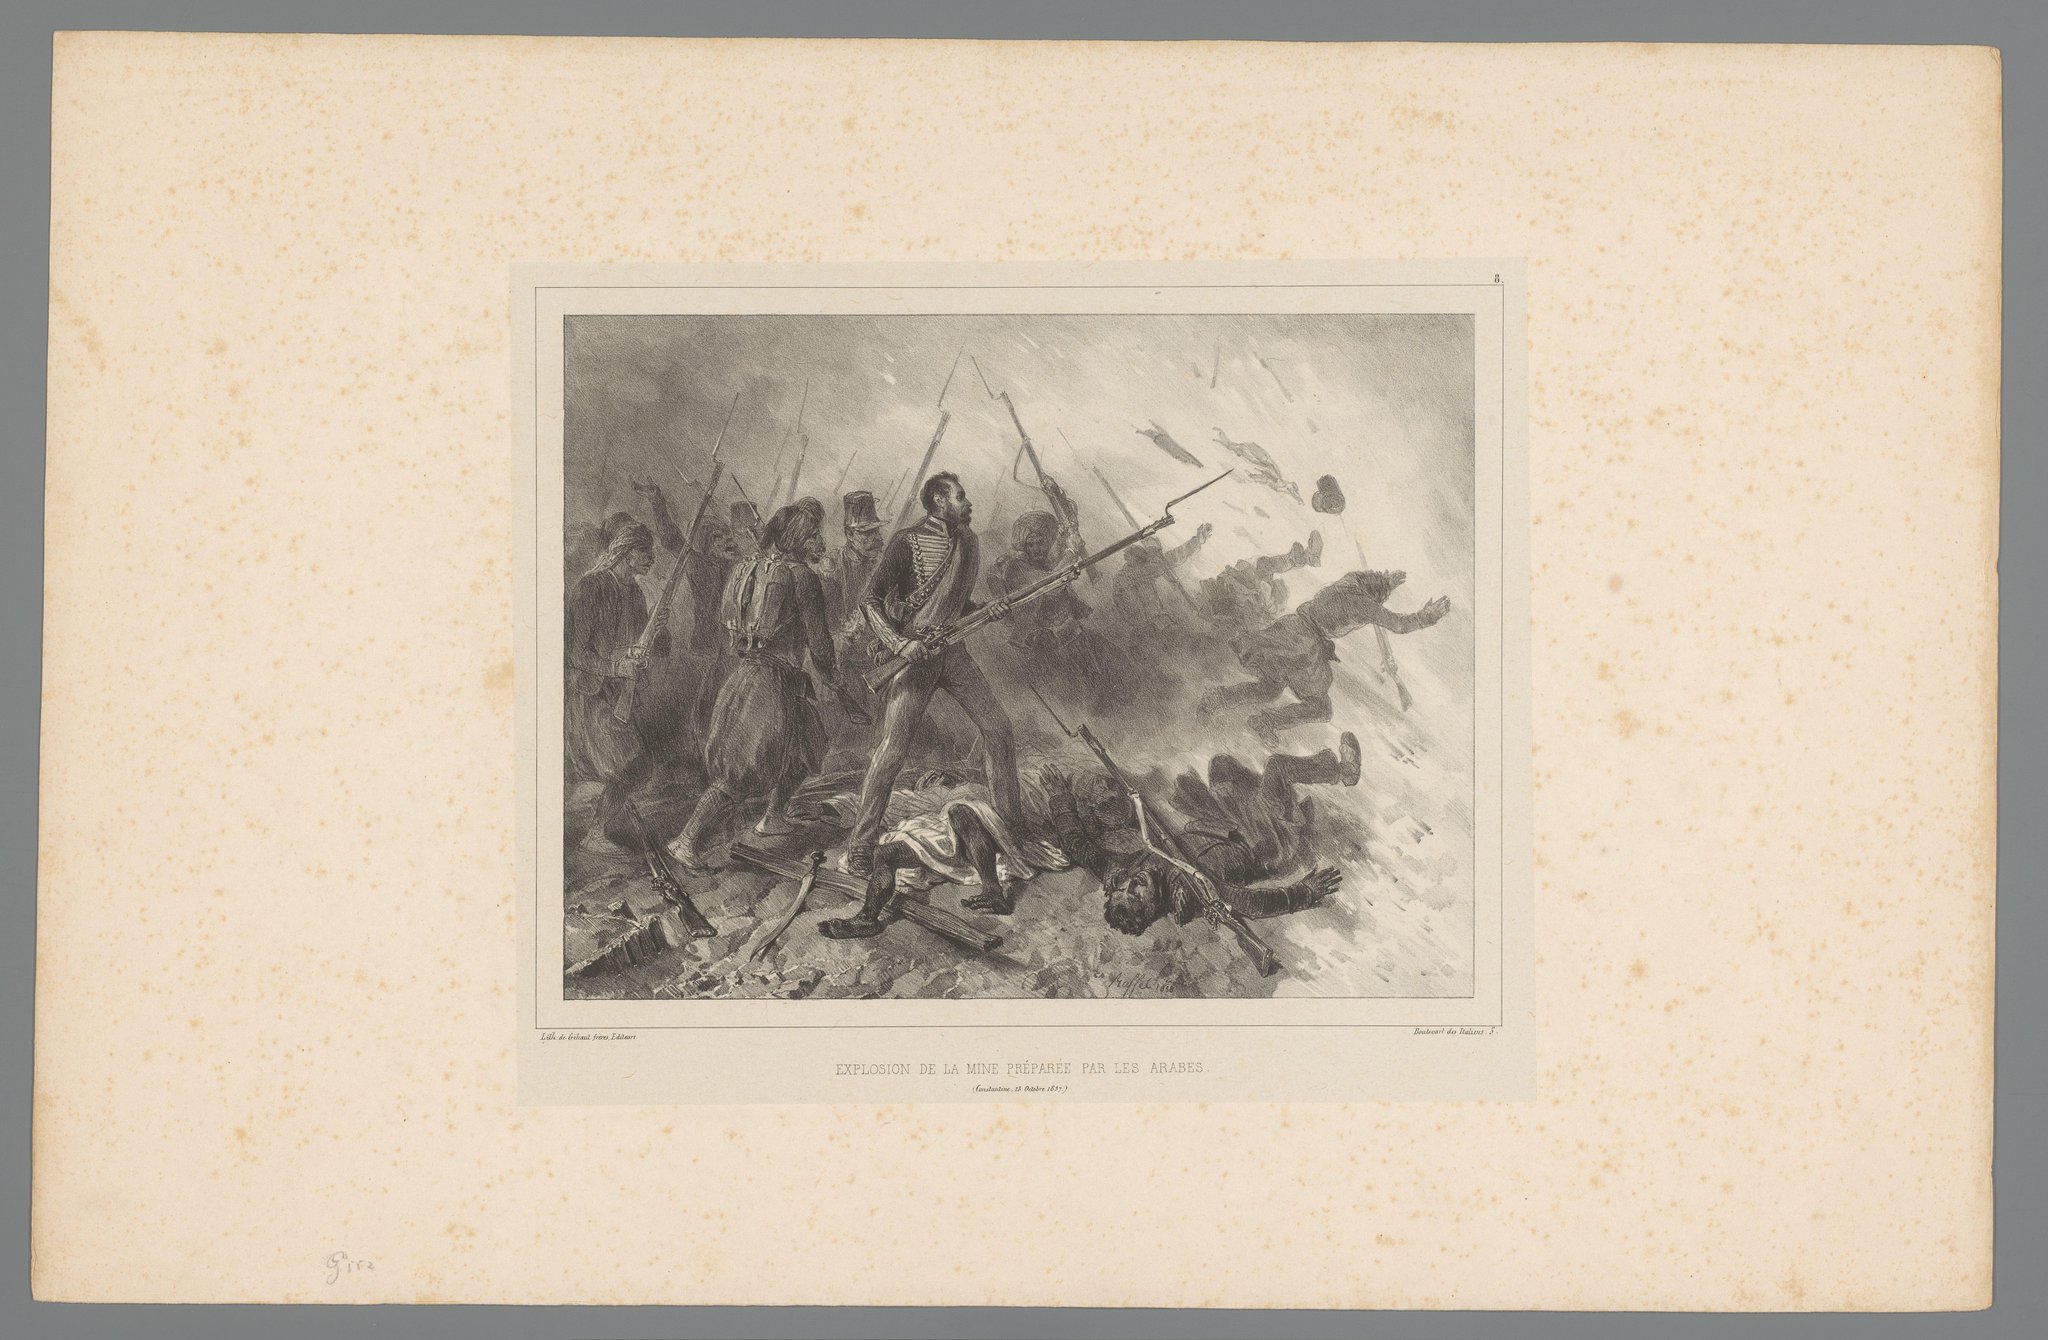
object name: print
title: Prise de Constantine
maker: denis auguste marie raffet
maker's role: draughtsman, print maker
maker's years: 1804-1860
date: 1838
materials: paper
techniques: lithograph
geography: paris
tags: projectiles, explosives, etc.: mine, firearms: rifle, (military) attack, the soldier; the soldier's life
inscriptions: collector's mark: Lugt 964